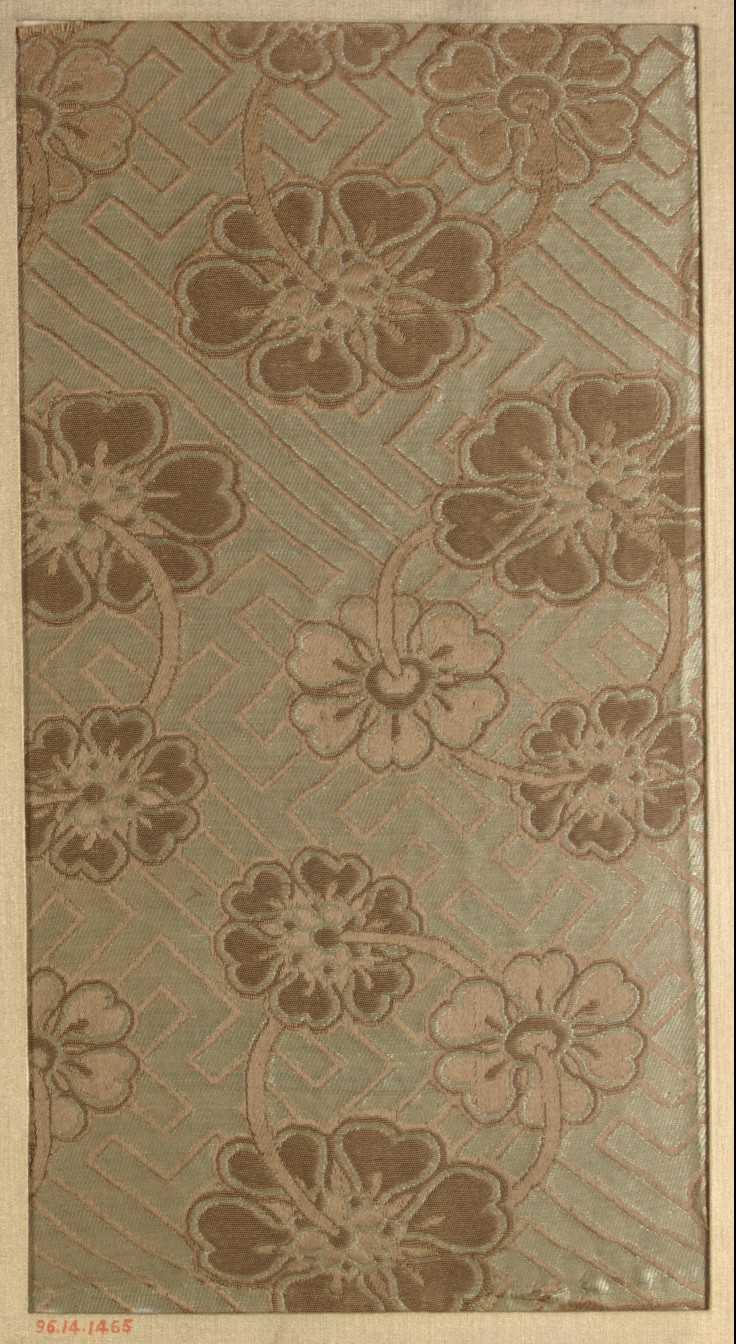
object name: piece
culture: japanese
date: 1701-1900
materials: silk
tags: flowers